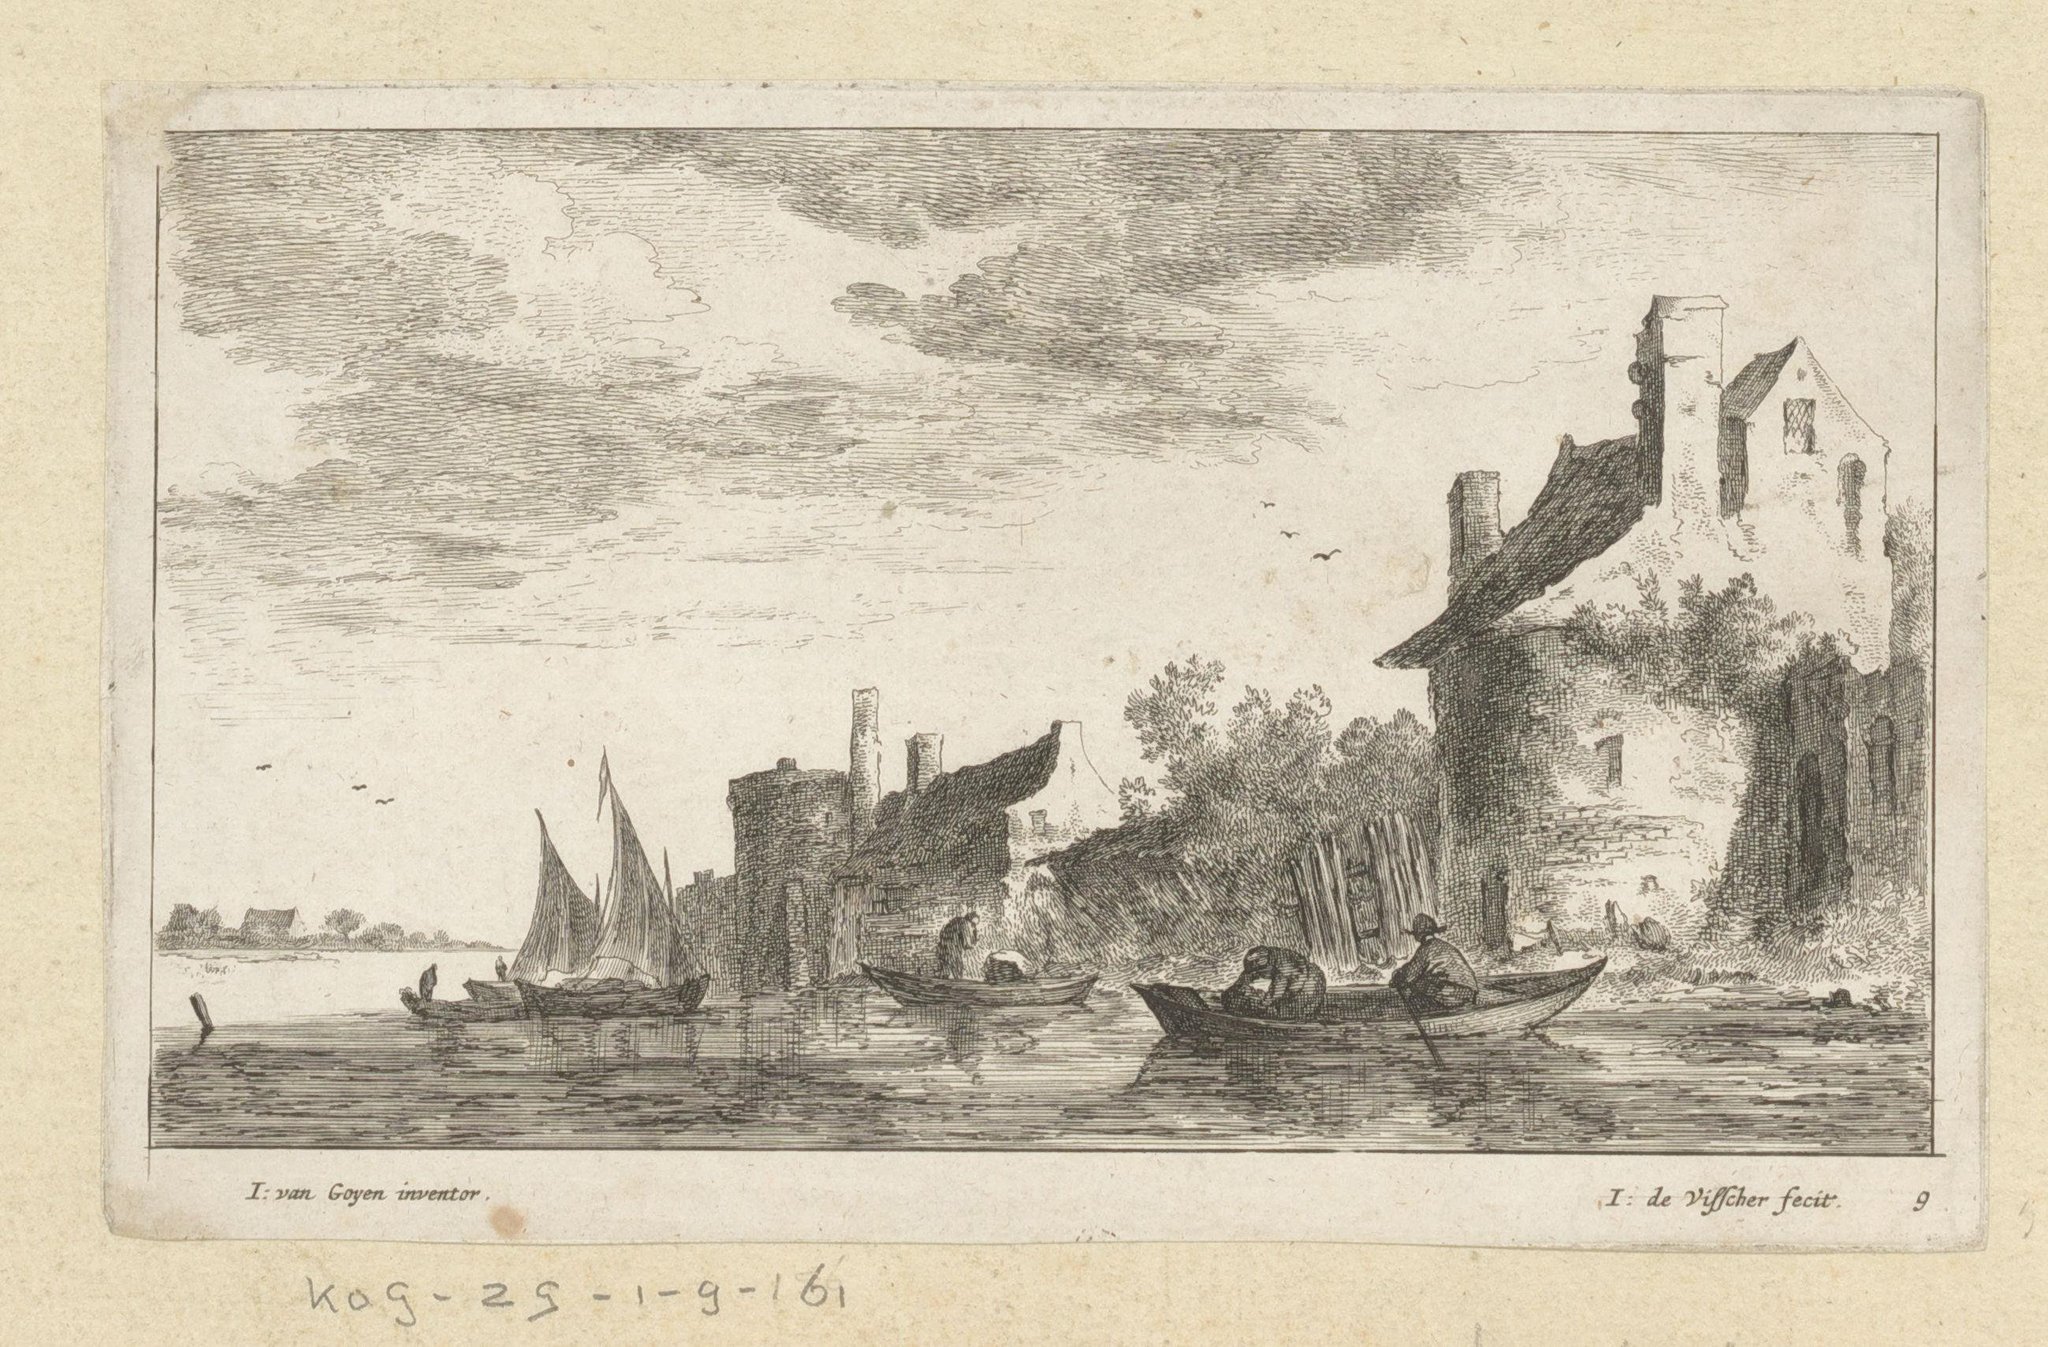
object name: print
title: Rivierlandschap met twee ronde torens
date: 1682-1709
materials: paper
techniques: engraving, etching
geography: amsterdam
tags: sailing-ship, sailing-boat, river, towers ~ fortified city, traffic on the water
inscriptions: stamp, collector's mark: Lugt 1641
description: Gezicht op een brede rivier met aan de rechterzijde enkele huizen en twee ronde torens. Aan de waterkant liggen verschillende bootjes. Rechtsonder genummerd: 9. Onderwerpsrubrieken binnen de Atlas Zeden en Gewoonten: Handel, nijverheid en verkeer, Buitenleven.